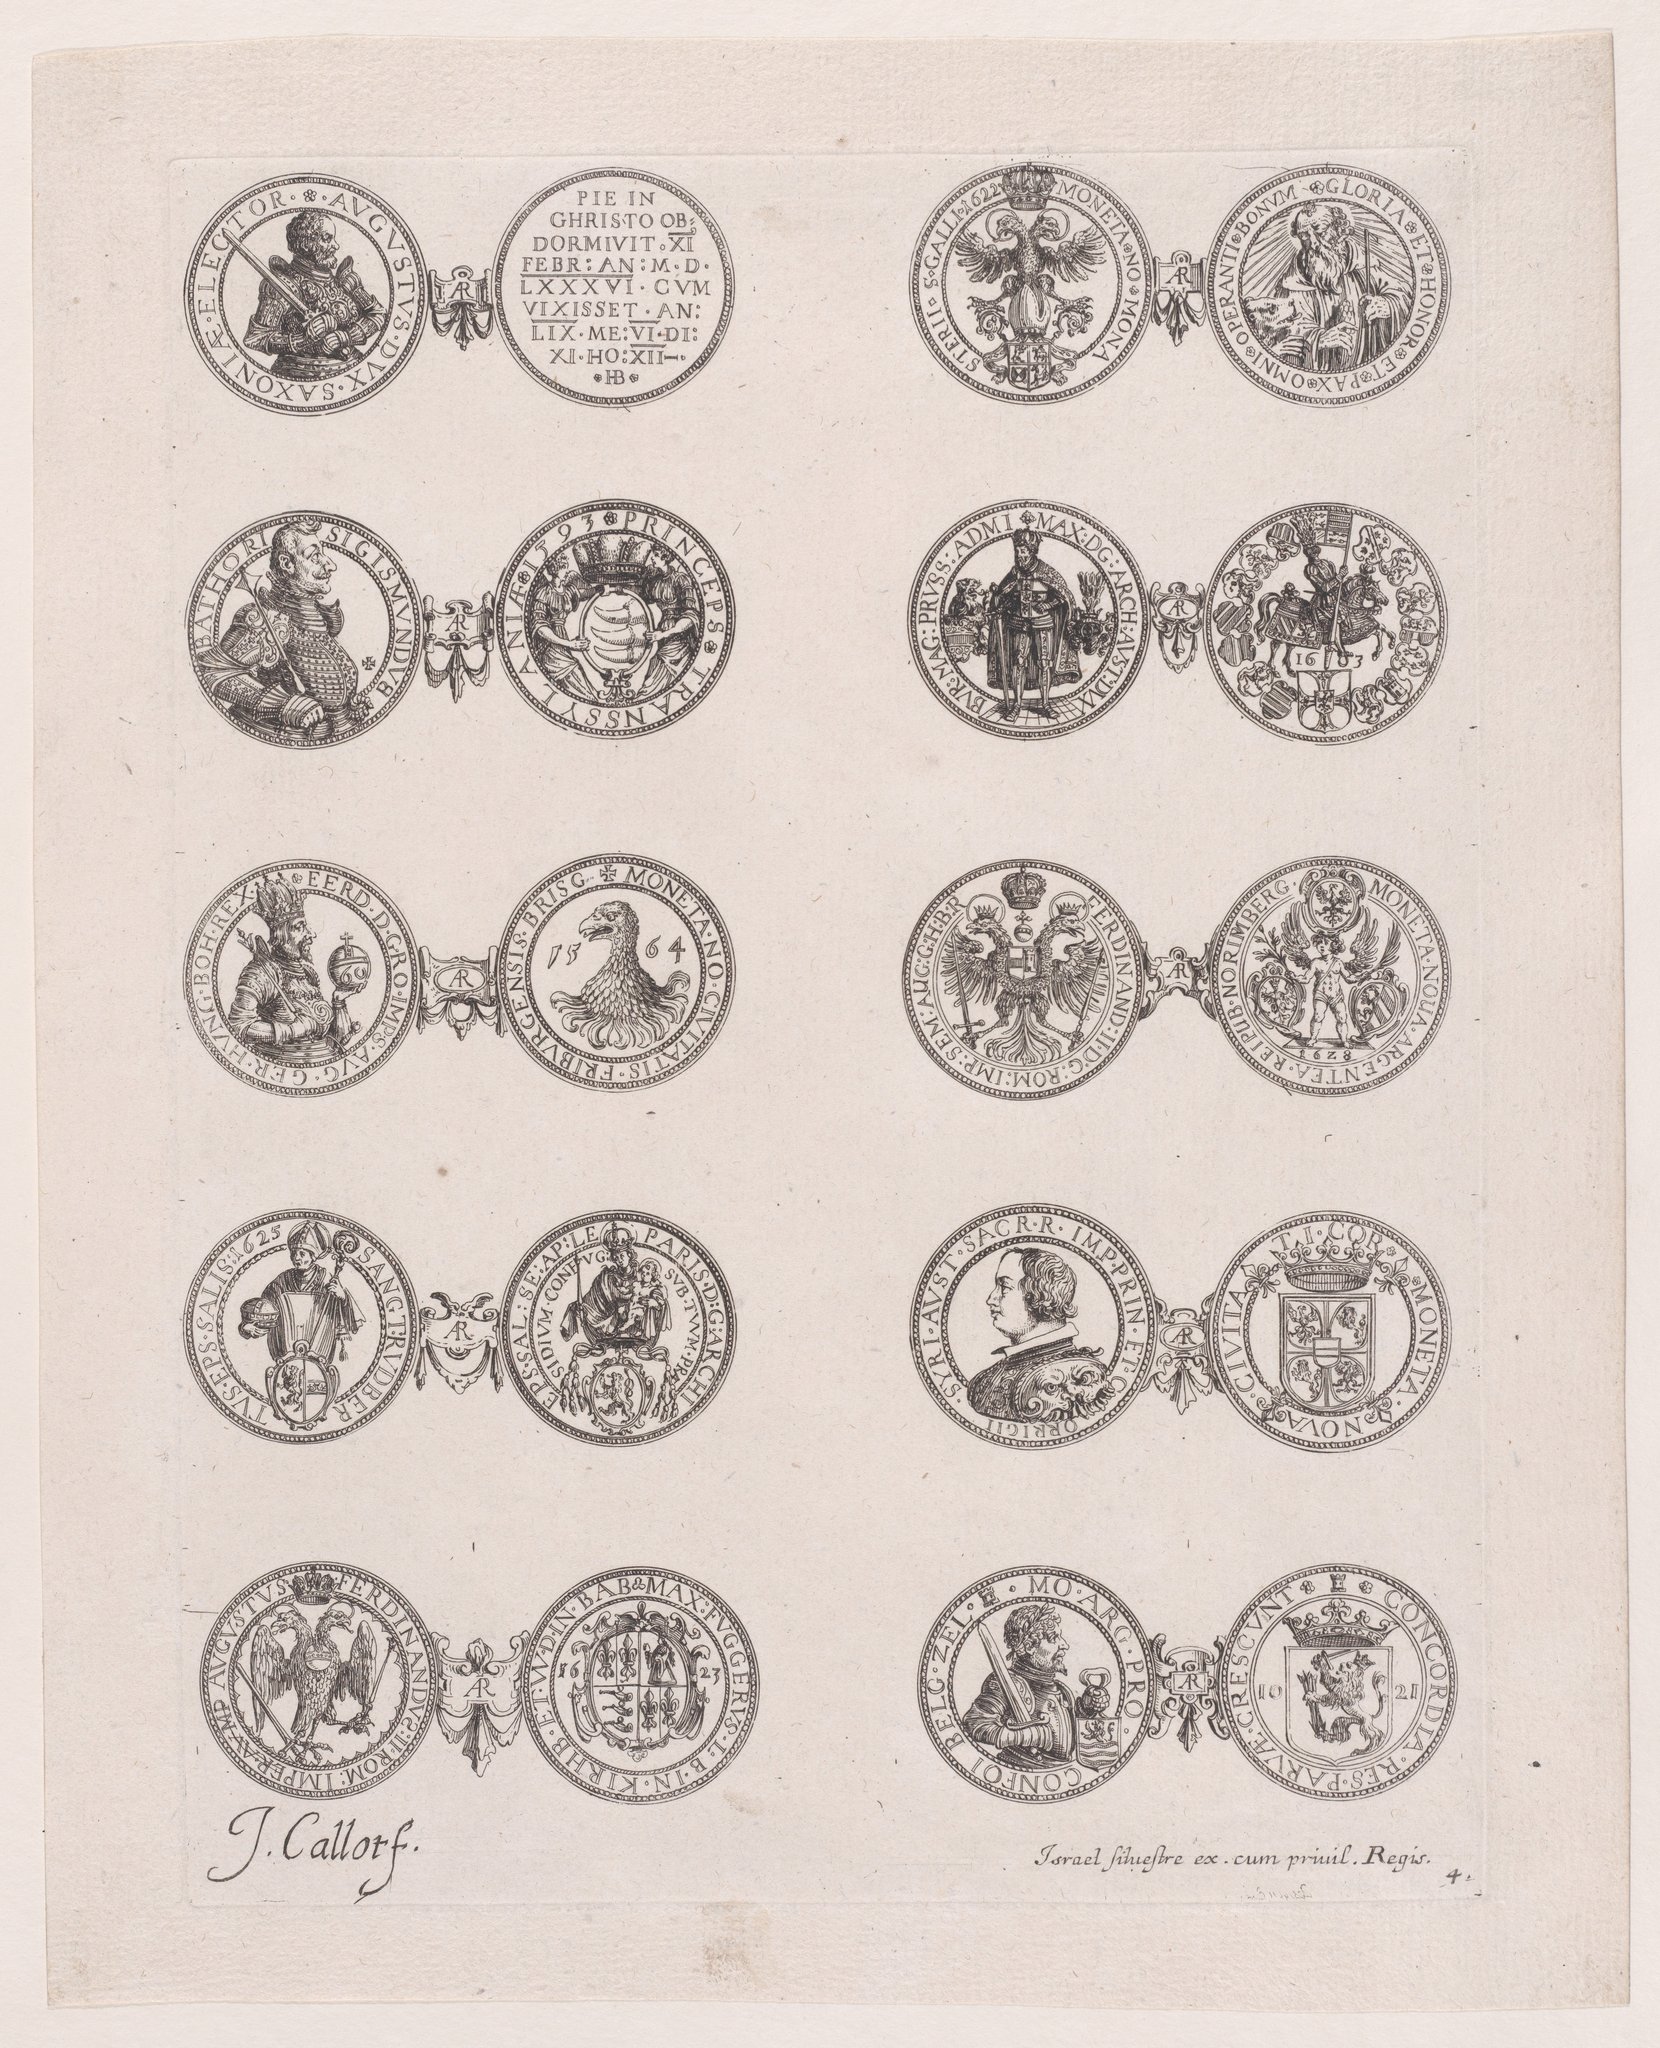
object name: print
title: Plate 4, Featuring 10 Coins Issued by European Princes in the 16th and 17th centuries, from "Les Monnaies" (The Currencies)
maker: jacques callot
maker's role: artist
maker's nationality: french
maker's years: 1592-1635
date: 1630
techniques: etching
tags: coins